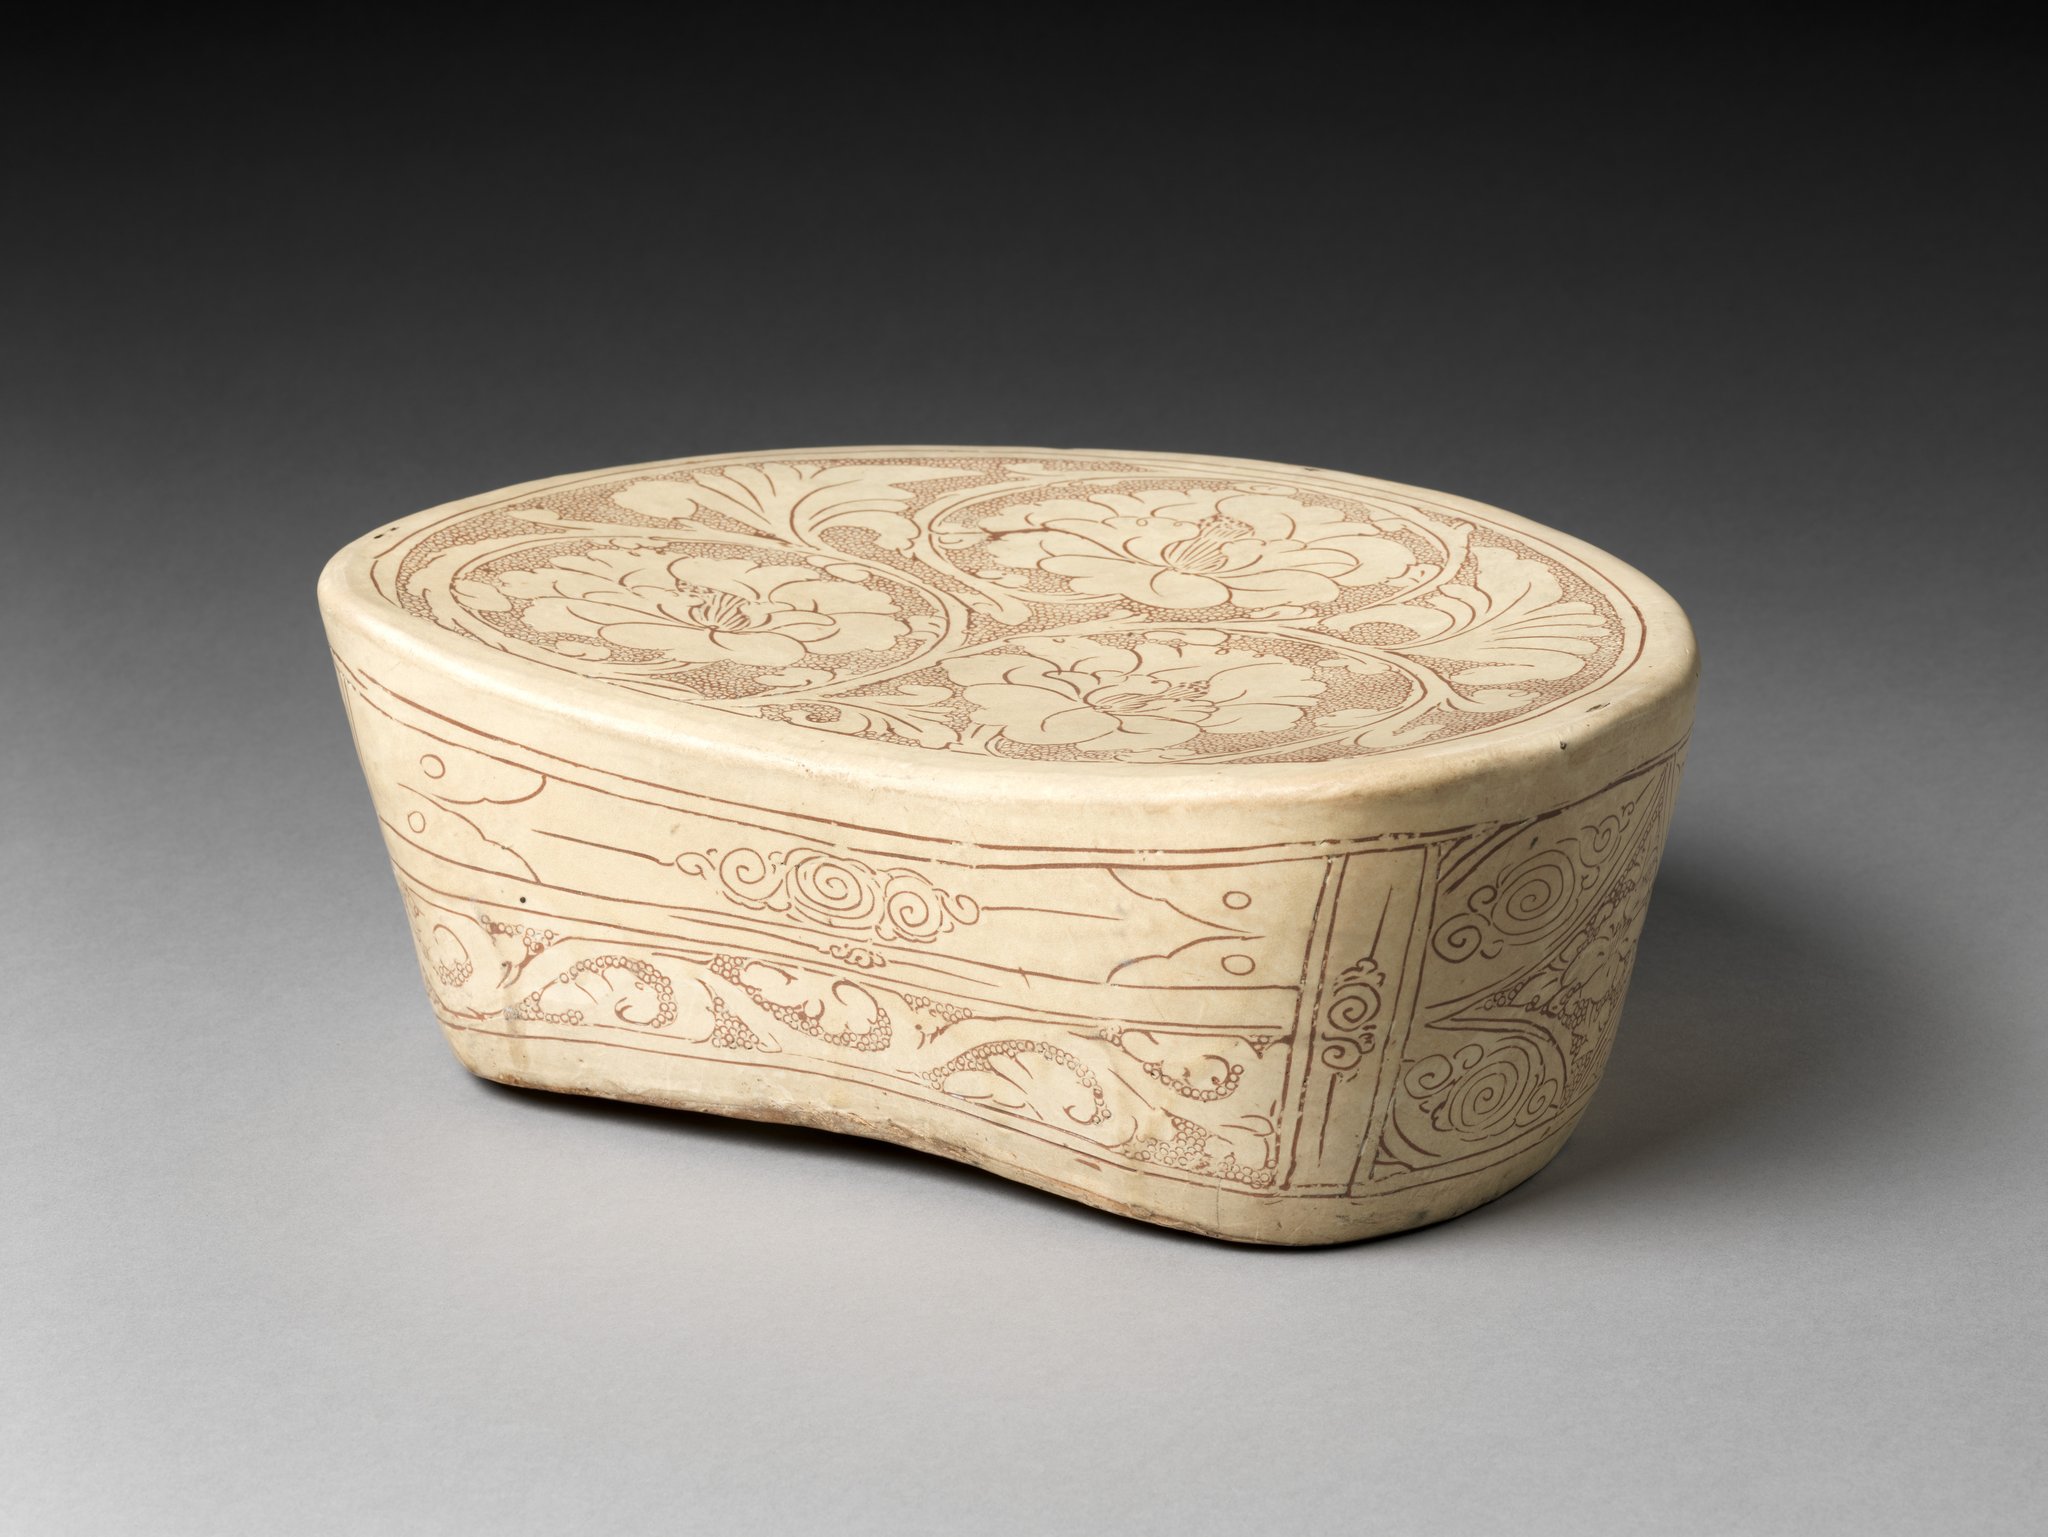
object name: pillow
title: Pillow with Peonies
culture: chinese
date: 1101-1300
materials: stoneware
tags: peonies